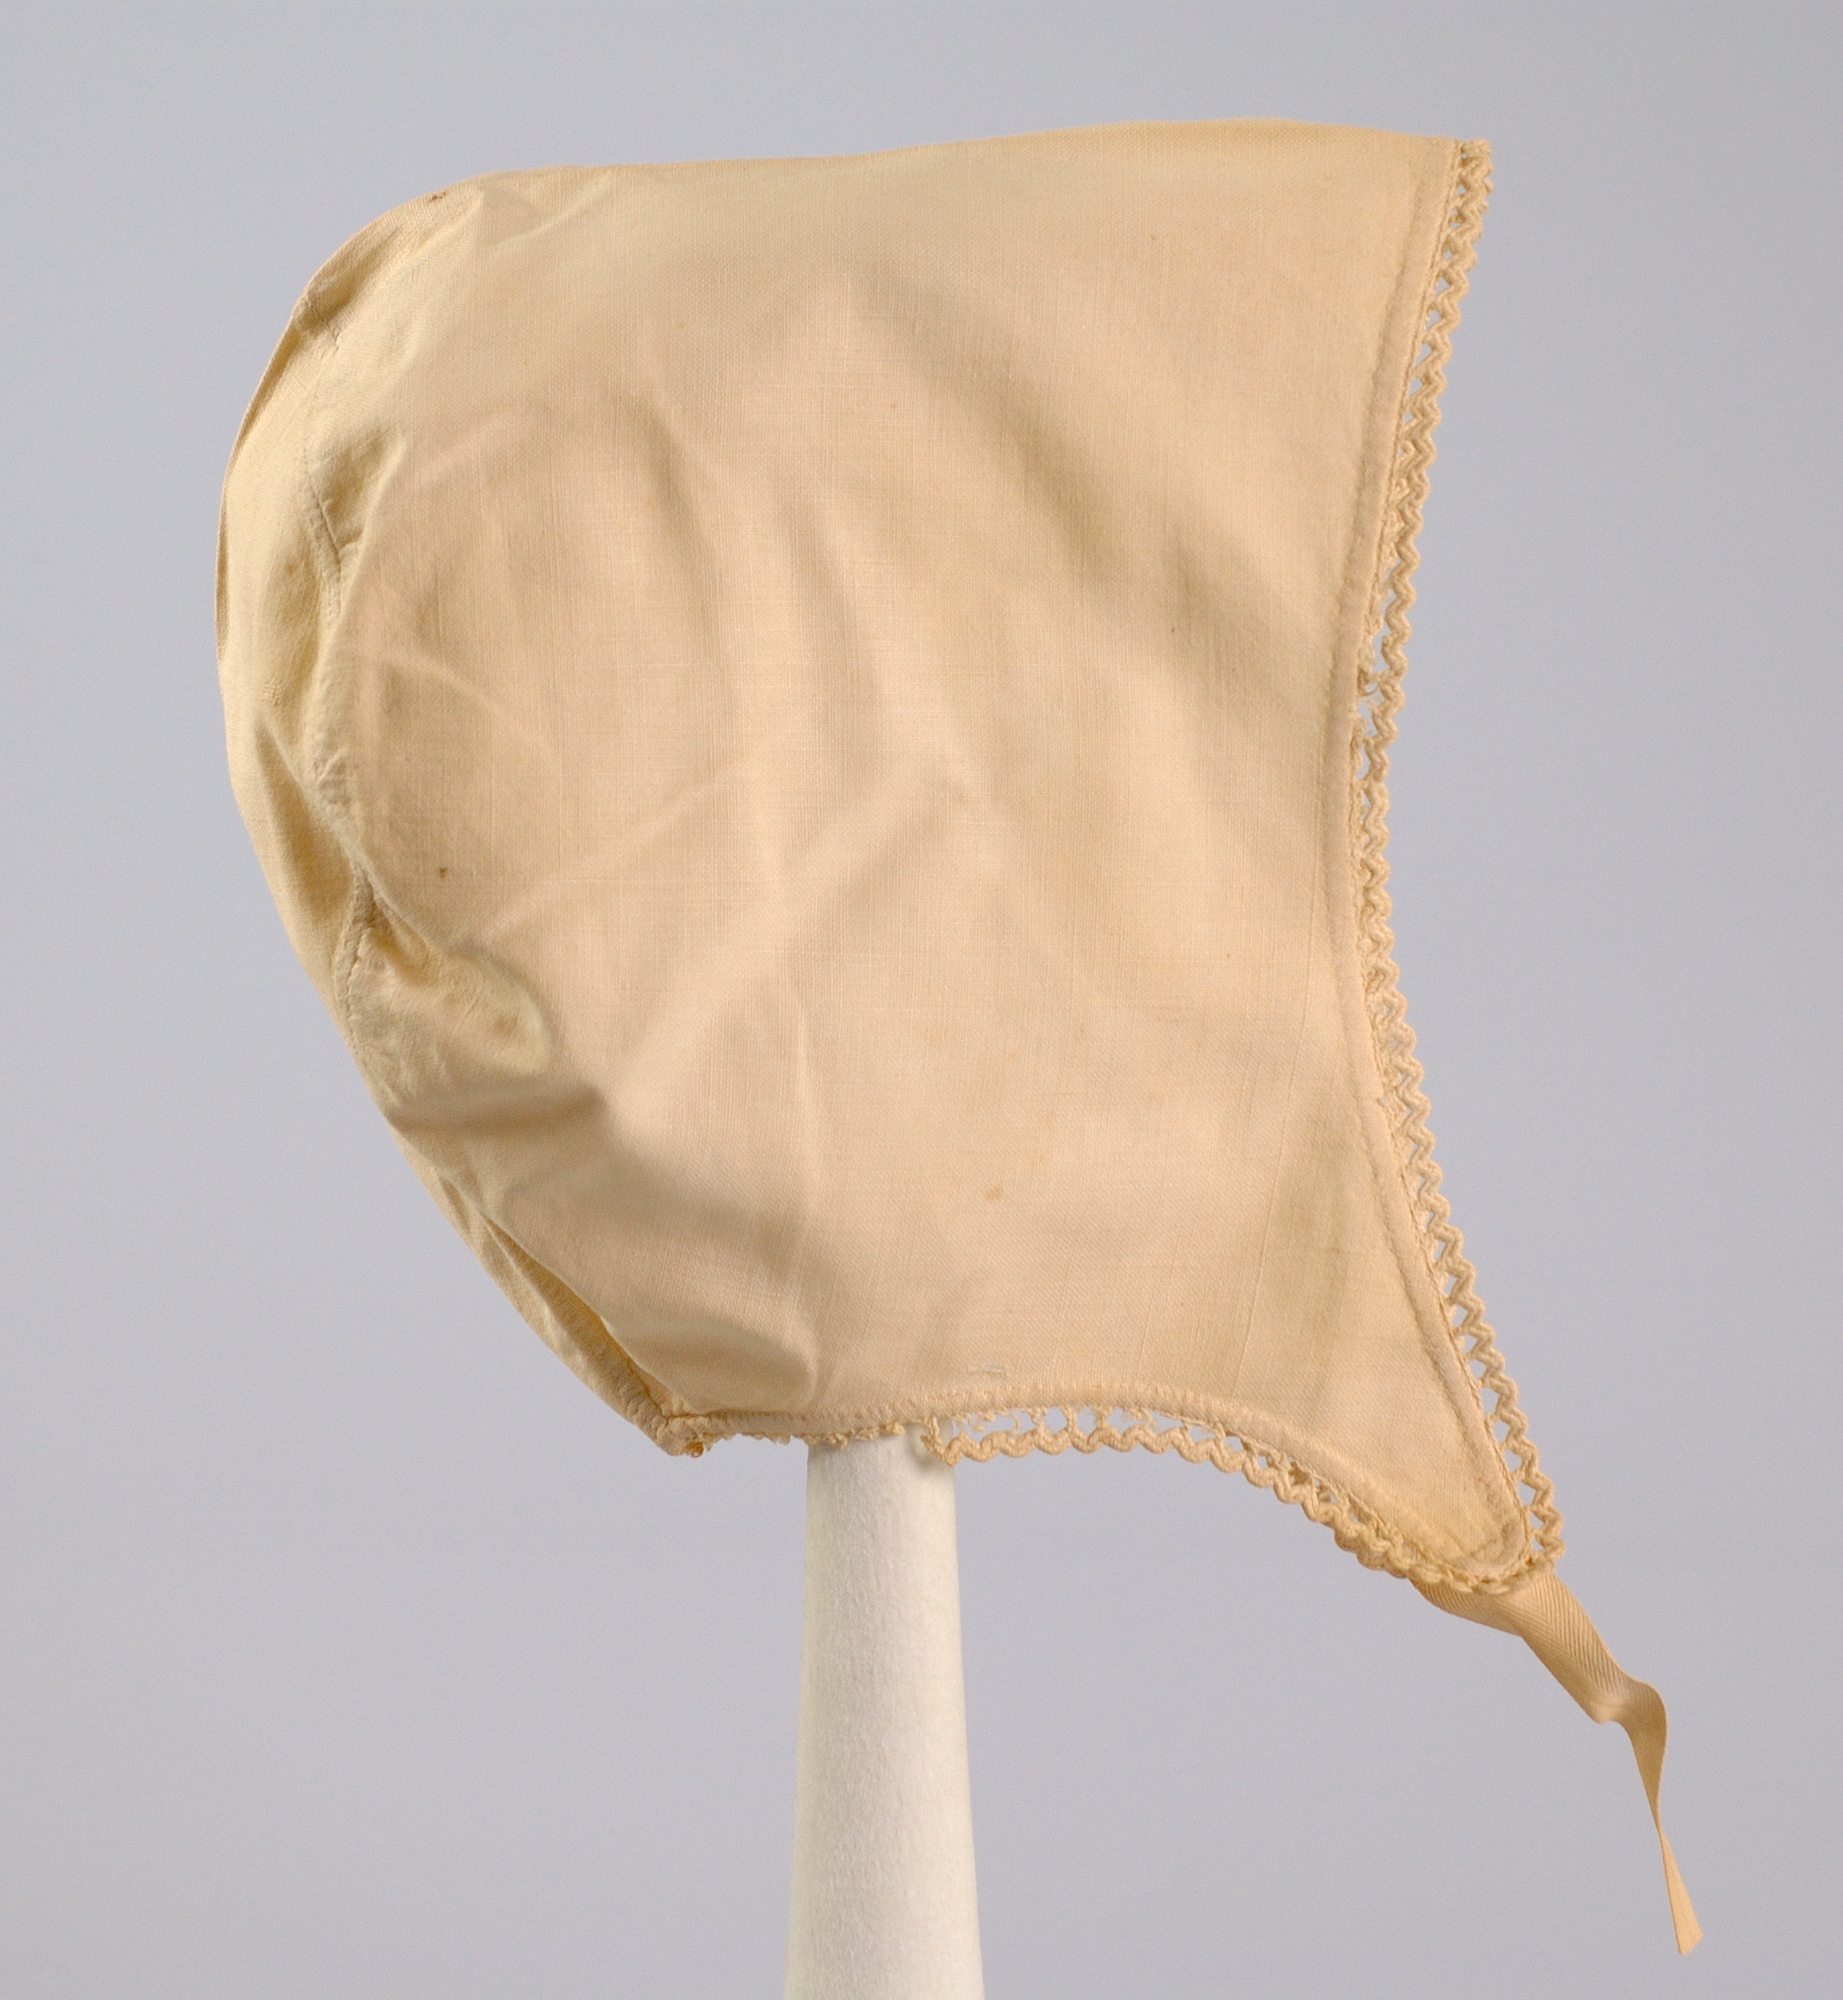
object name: nightcap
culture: american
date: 1868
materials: linen